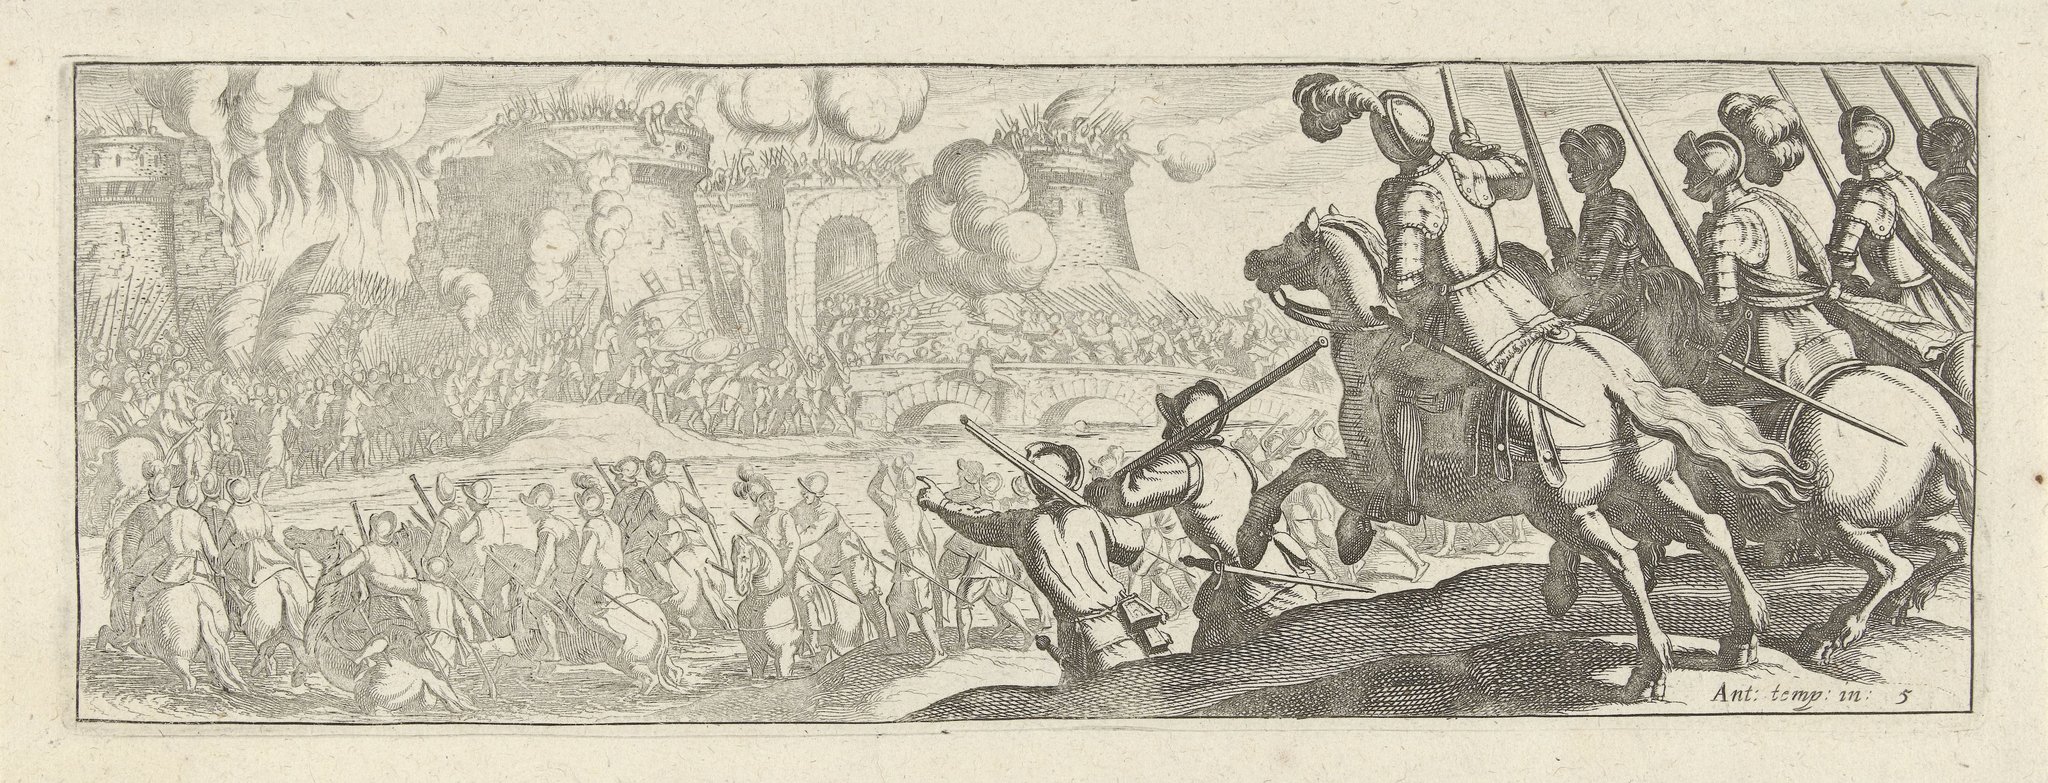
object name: print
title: Faecvnda qvam sit acris ingeni viris dilecta Phaebo et gratys Florentia, sat indicant pvgnae, enthea vi pectoris quas Mercuri sculpsit cliens tempestiv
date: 1595-1628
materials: paper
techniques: etching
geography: northern netherlands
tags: breaking into city or fortress ~ siege (+ cavalry, horsemen)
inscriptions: collector's mark: Lugt 2228